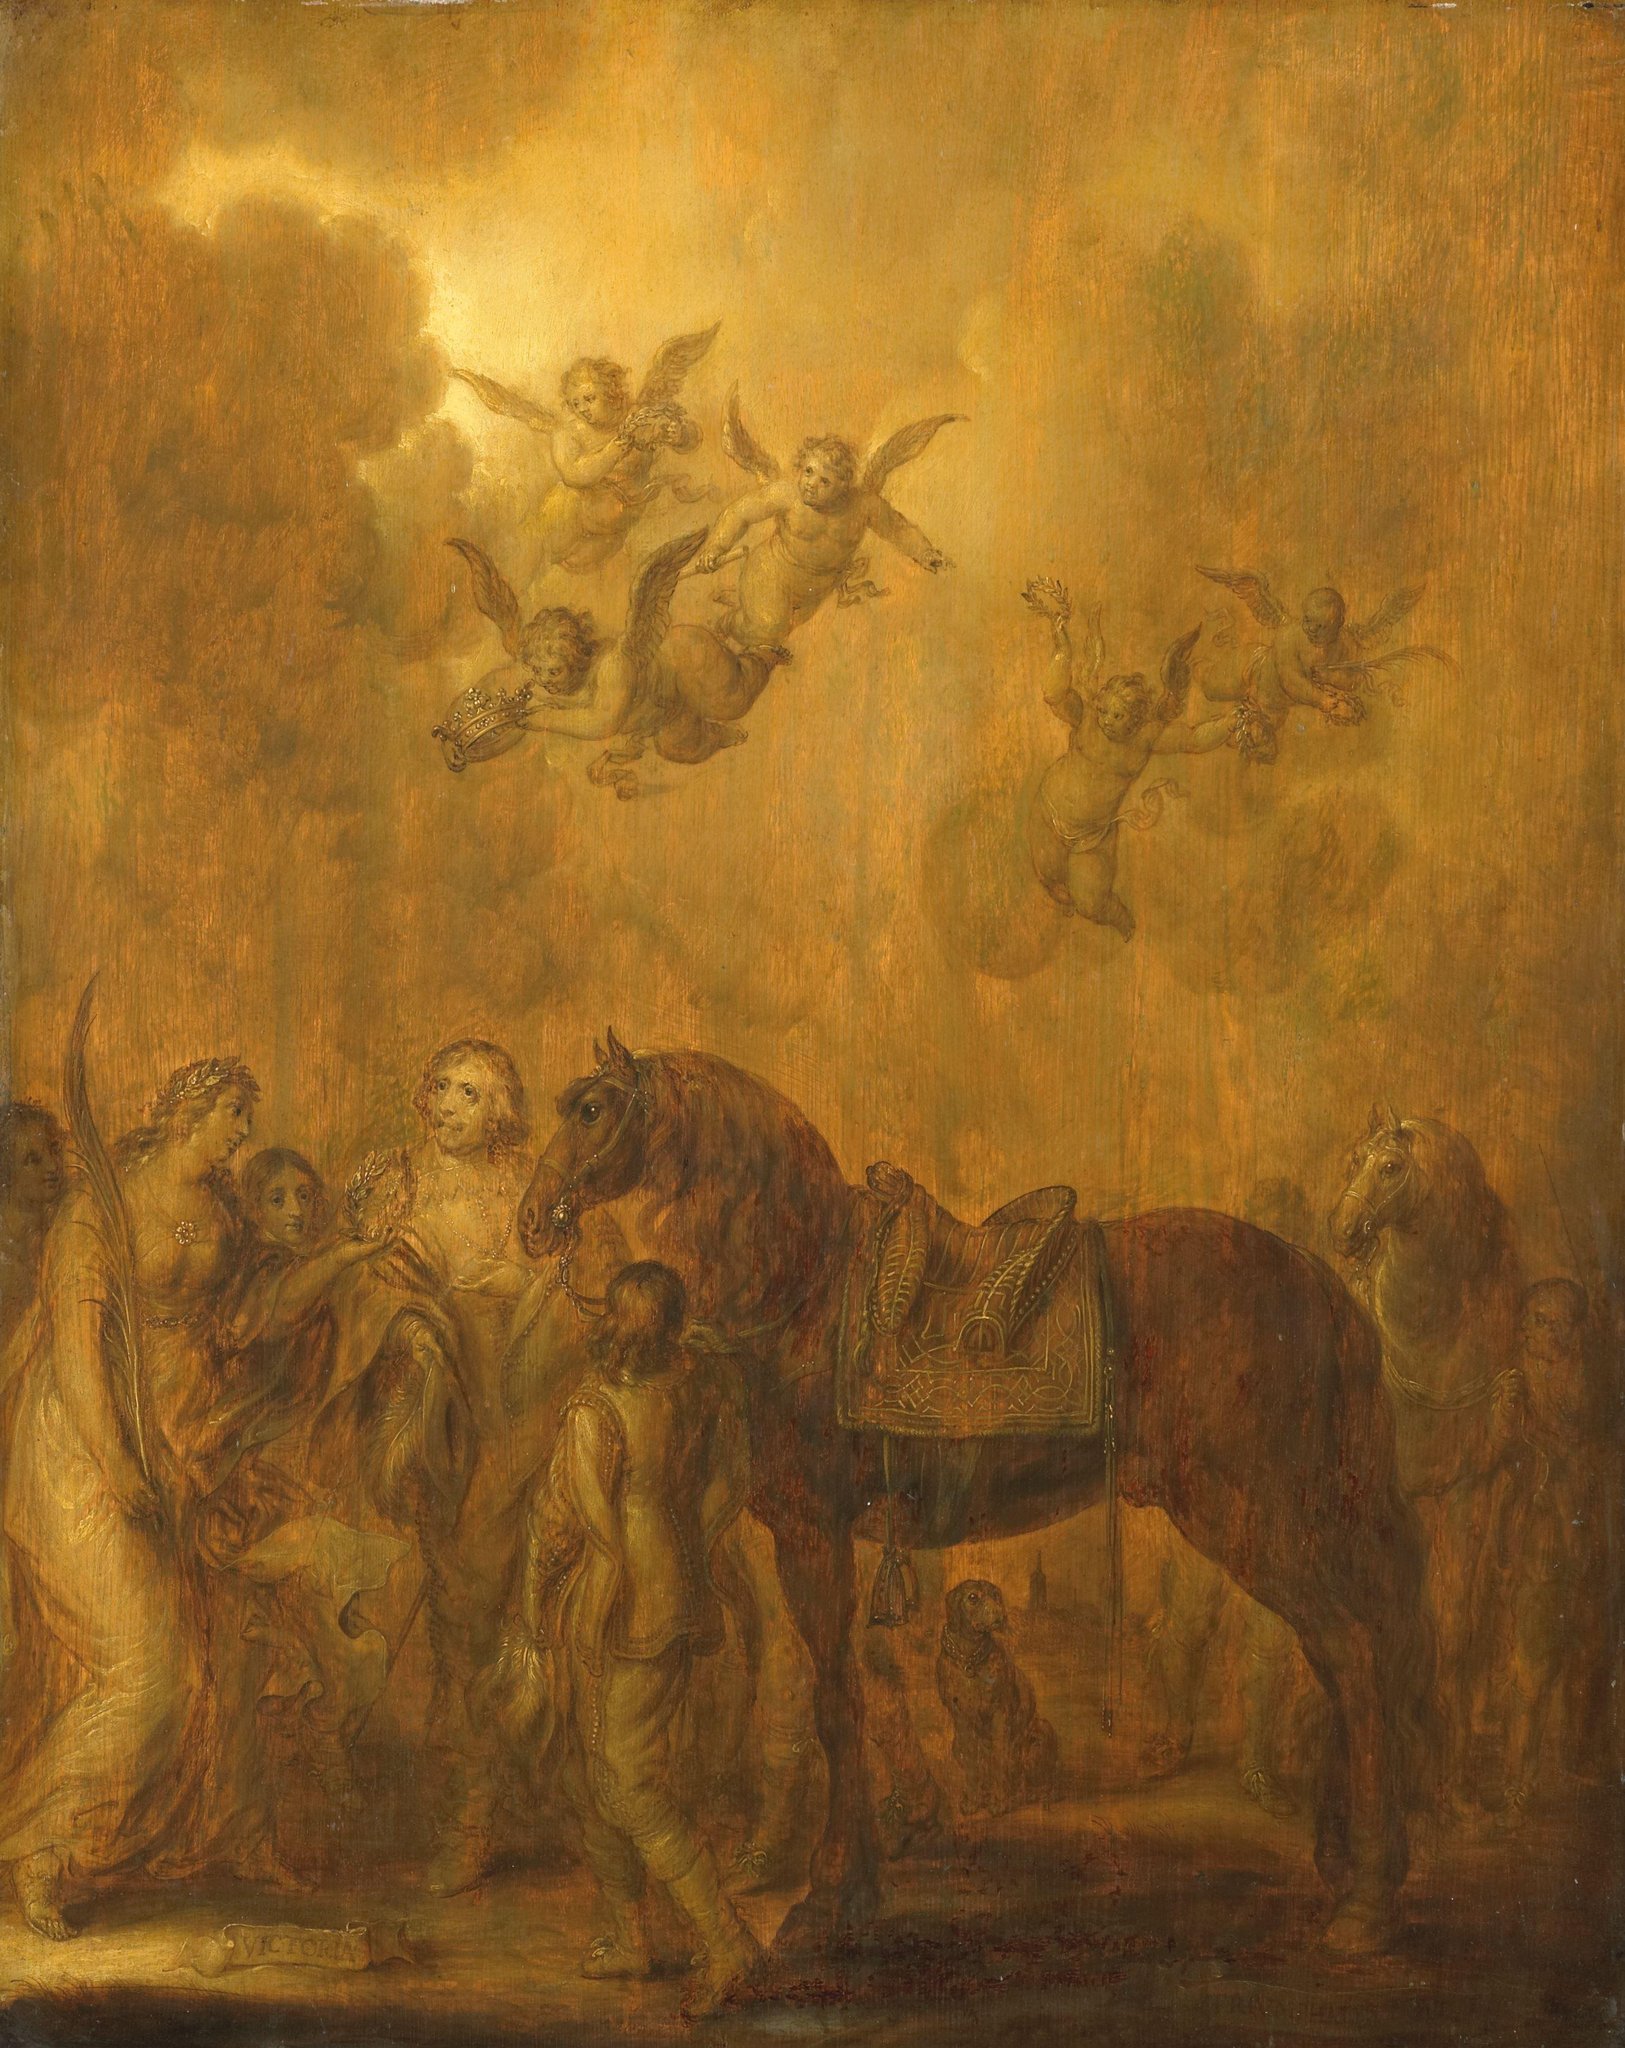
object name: painting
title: Allegory of the Stadtholdership of Prince Frederick Henry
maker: adriaen pietersz van de venne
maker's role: draughtsman, painter, print maker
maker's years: 1589-1662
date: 1642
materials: oil, panel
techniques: grisaille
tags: frederick henry (prince of orange), william ii (prince of orange), historical persons, 'victoria'; 'vittoria', 'vittoria navale', 'vittoria degl'antichi' (ripa)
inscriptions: signature and date, bottom left (A and D ligated): ‘AD [.] Ven[.]e 1642’, inscription, bottom left: ‘VICTORIA’, inscription, bottom right: ‘TRIVMPHALIS FQNI’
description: Allegorie op het stadhouderschap van prins Frederik Hendrik. De vrouwelijke personificatie Victoria met palmtak overhandigt de stadhouder een lauwerkrans, staande tussen hen in kijkt Willem II toe. Een knecht houdt de teugels van een paard. In de lucht vliegen engeltjes met een kroon en lauwerkransen.